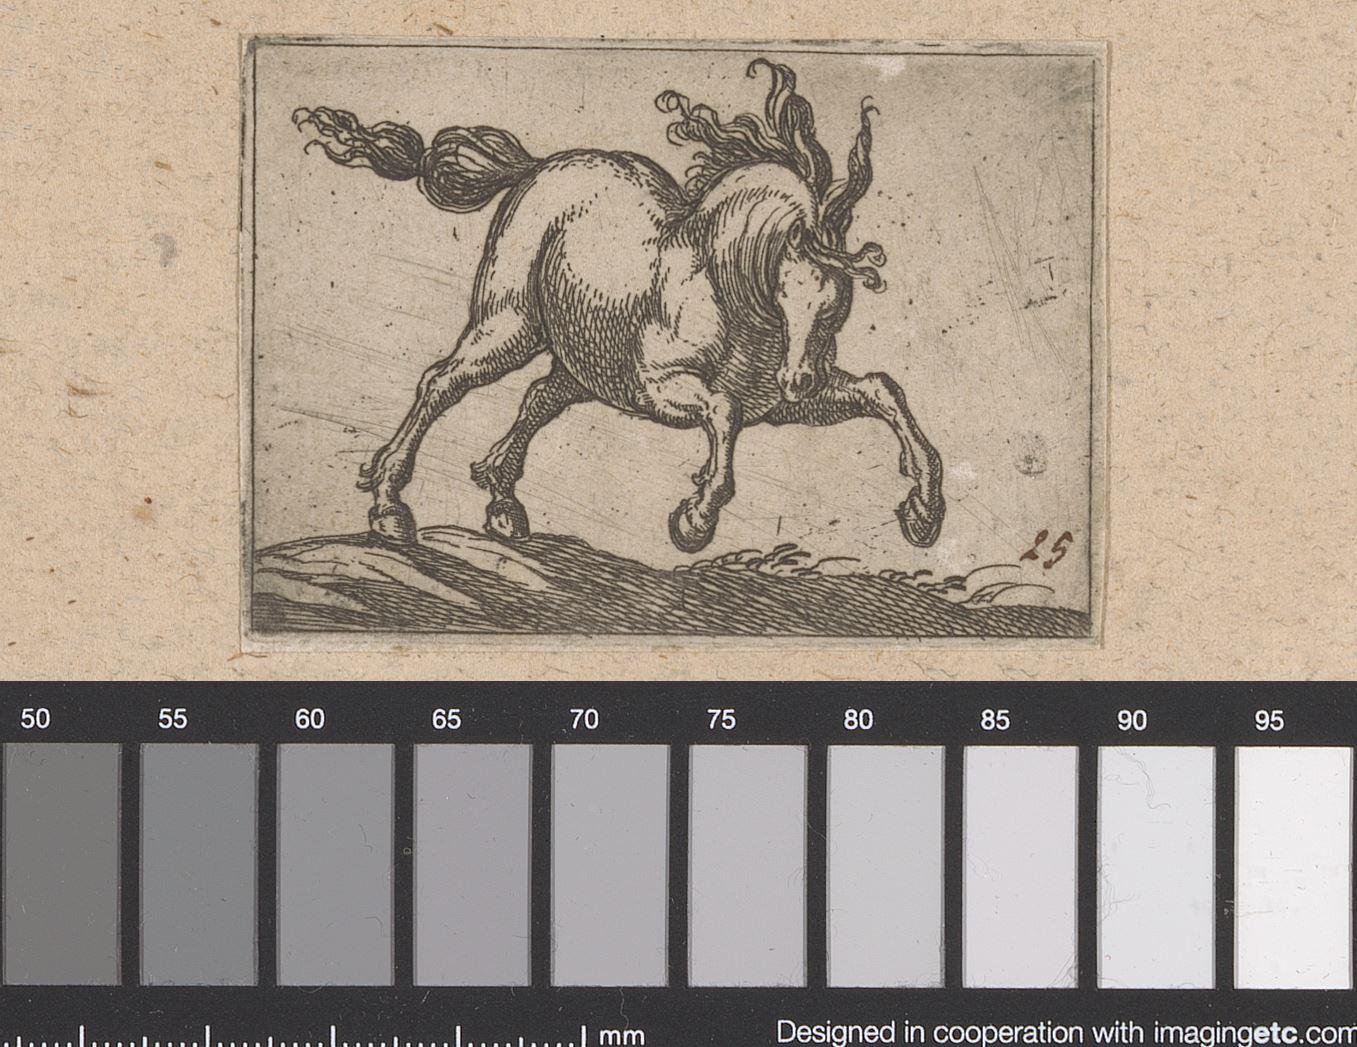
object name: print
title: Springend paard van voren gezien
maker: antonio tempesta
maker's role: draughtsman, painter, print maker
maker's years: 1555-1630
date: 1565-1630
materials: paper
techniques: etching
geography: italy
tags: horse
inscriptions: number: ‘25’, collector's mark: Lugt 11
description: Deze prent maakt deel uit van een reeks van 24 prenten van paarden.